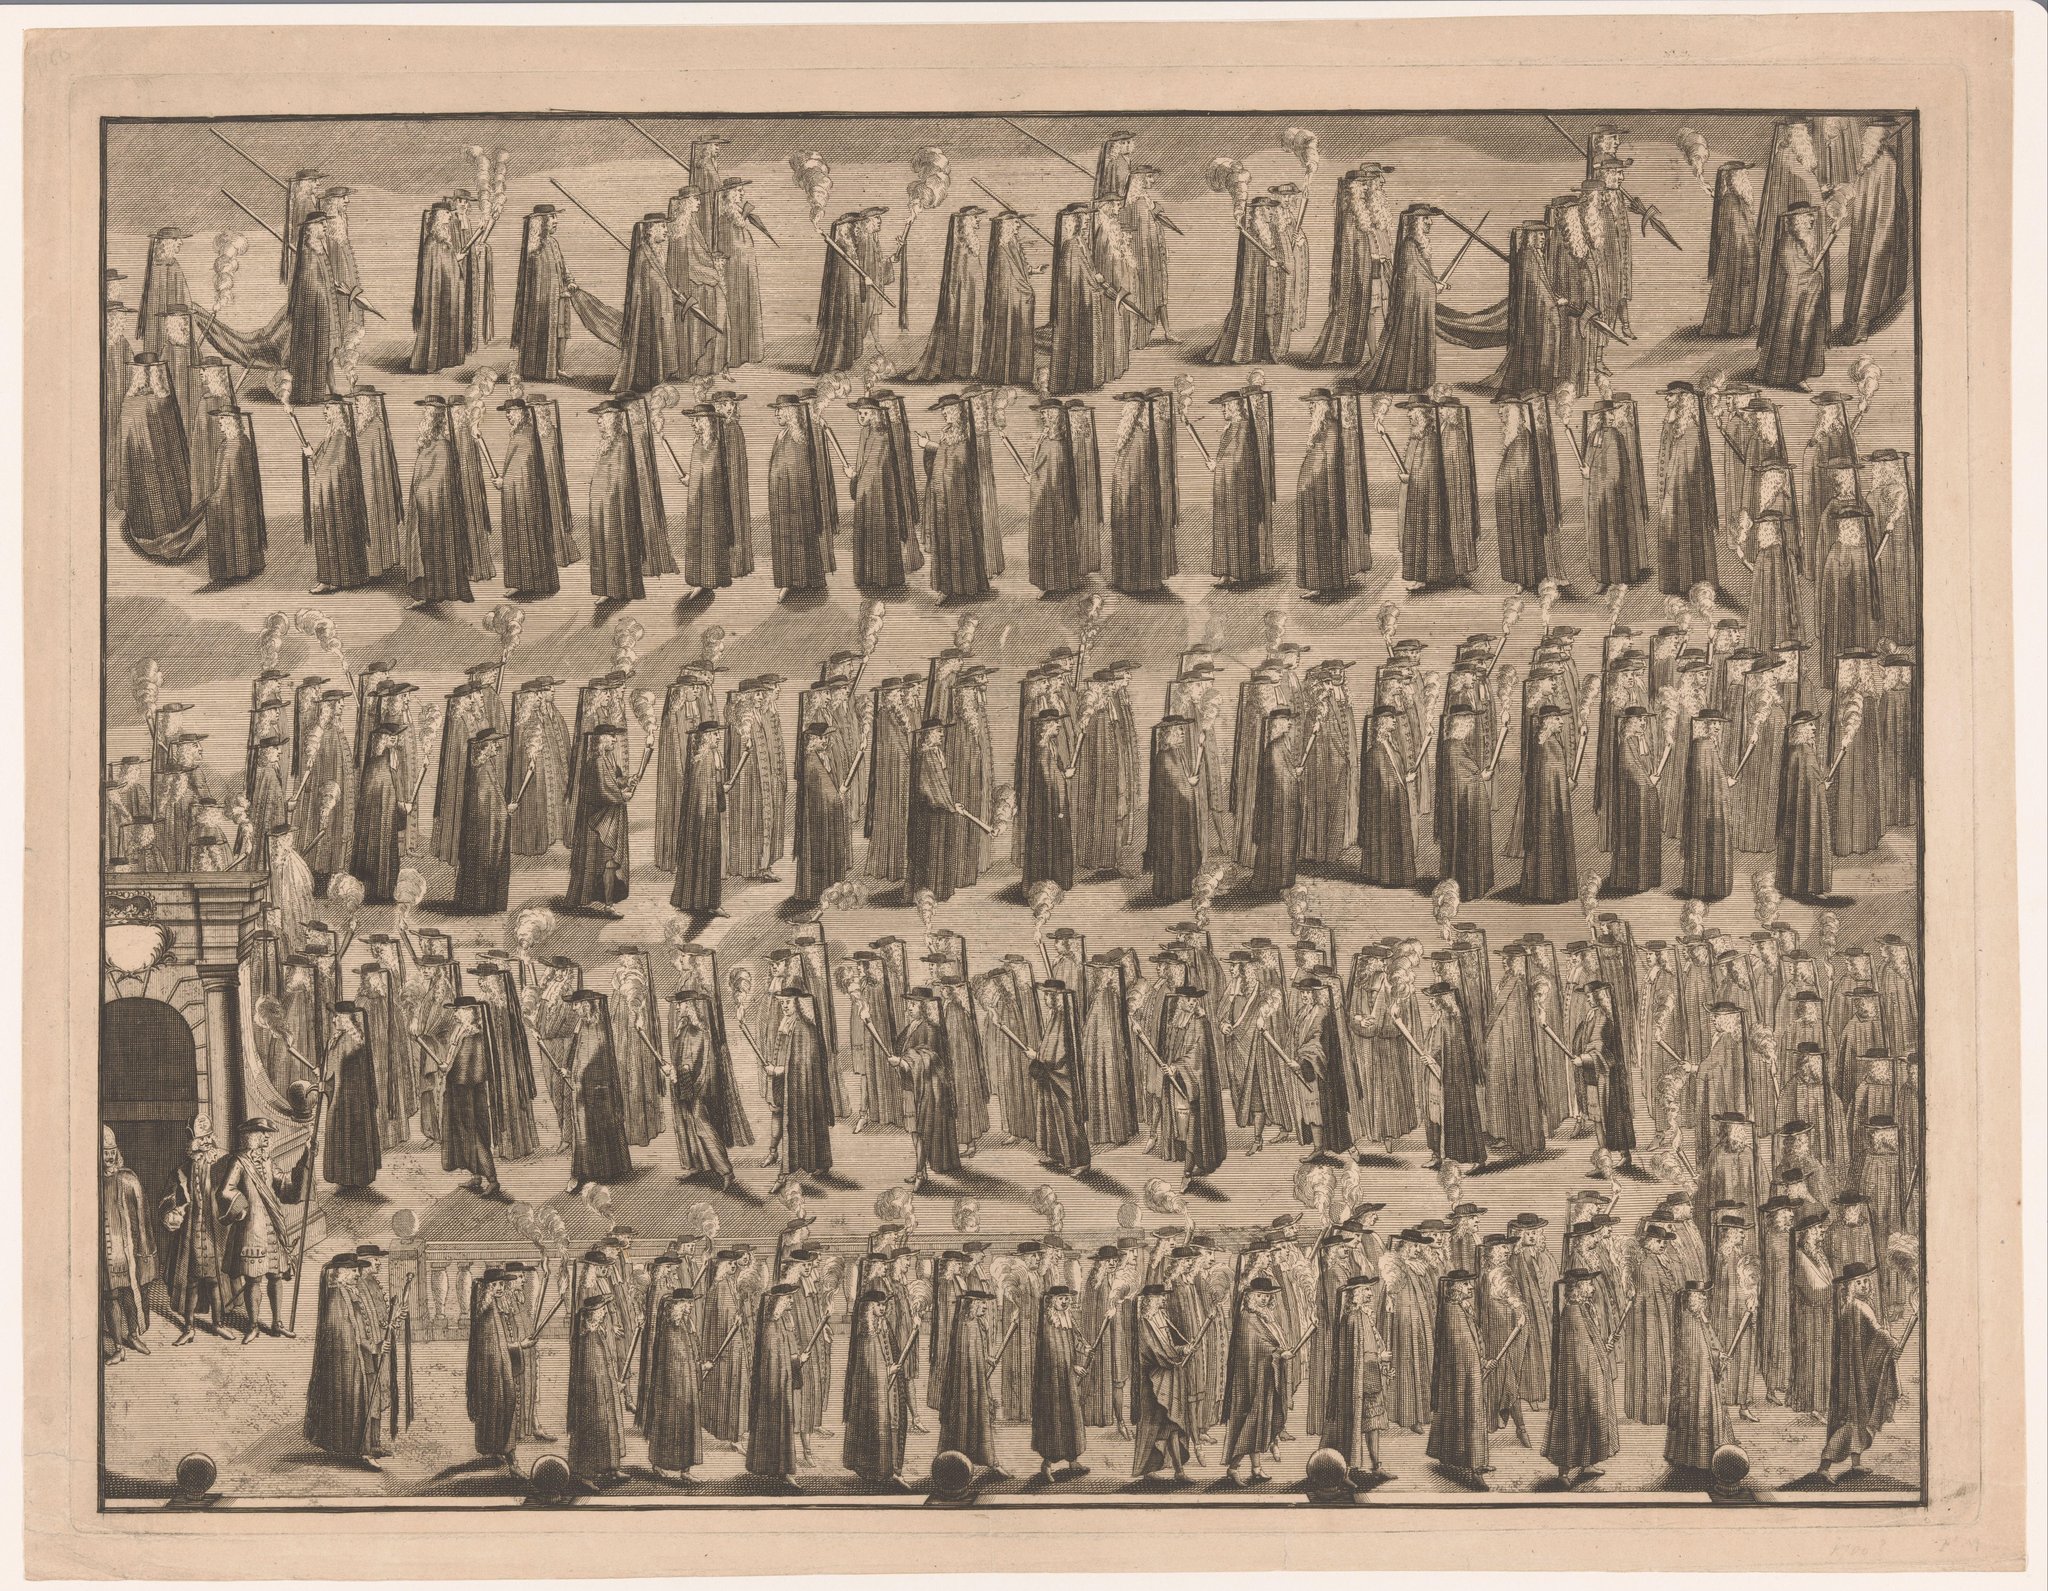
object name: print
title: Begrafenisstoet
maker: Anonymous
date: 1600-1699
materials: paper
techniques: etching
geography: germany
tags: funerary ceremonial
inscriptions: collector's mark: Lugt 2228